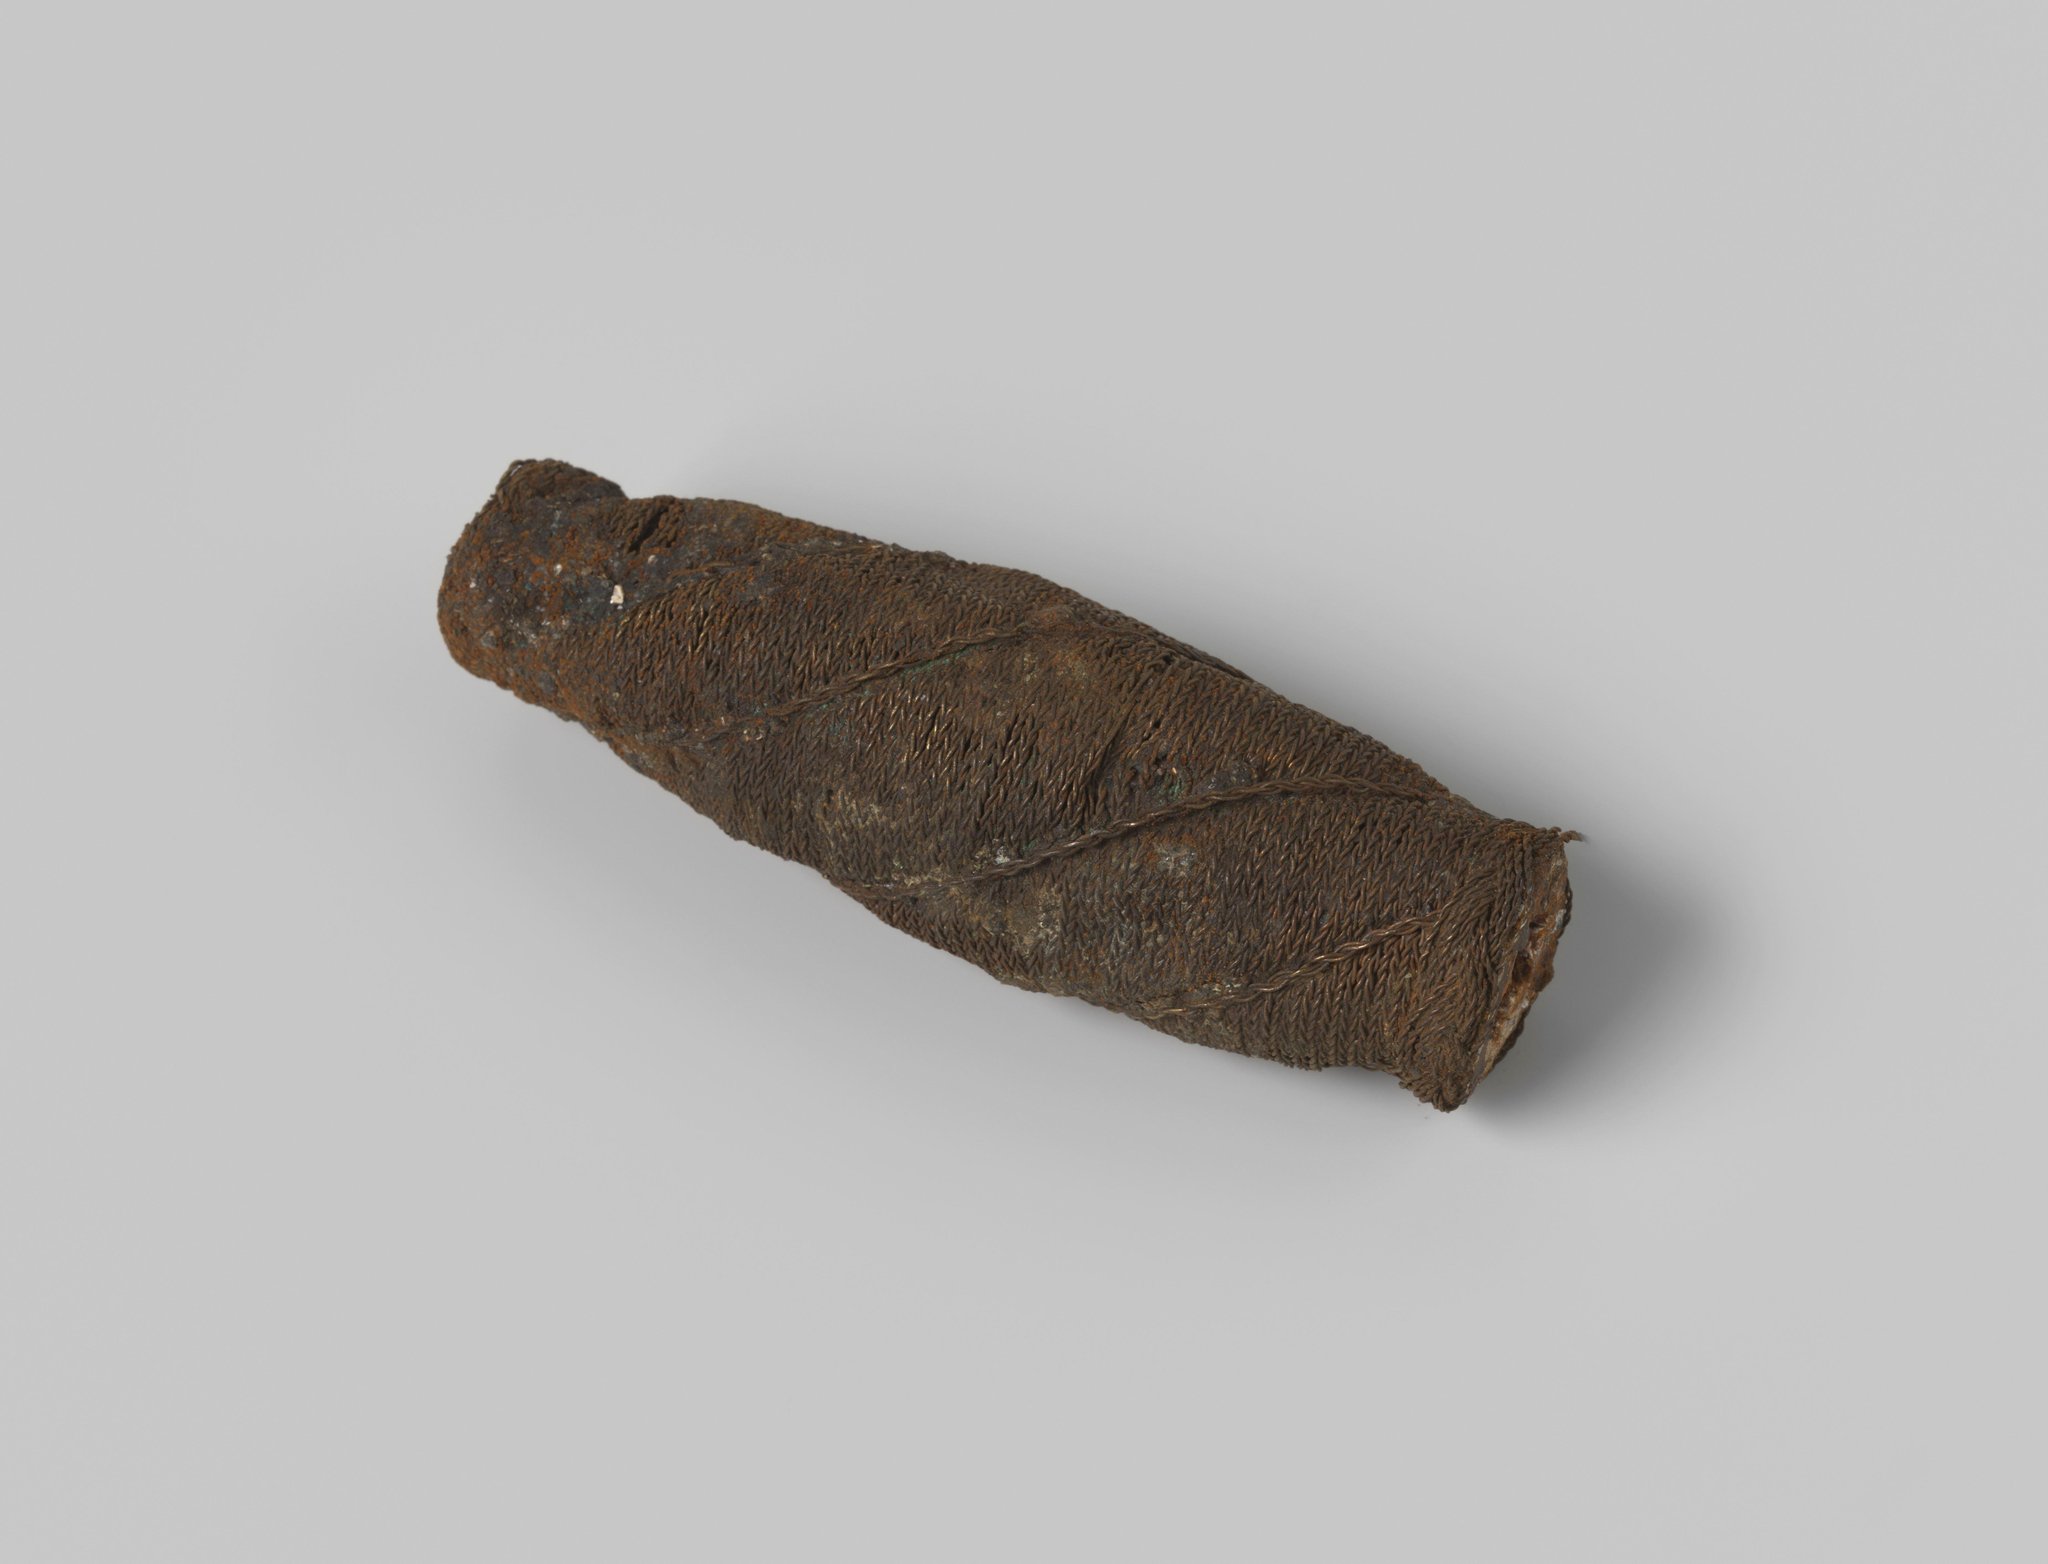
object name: greep gevest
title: Greep van een gevest uit het wrak van de Oost-Indiëvaarder Hollandia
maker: Anonymous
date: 1700-1743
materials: copper, wood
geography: netherlands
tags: verenigde oostindische compagnie, hollandia (schip), annet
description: Hilt, grip; wood core, circular in section, tapering toward straight ends, bulbous centre par, bound with two-strand copper wire and 1 diagonal strip of three-strand copper wire, ferrules on both ends of plaited two-strand copper wire, rectangular tang bore.